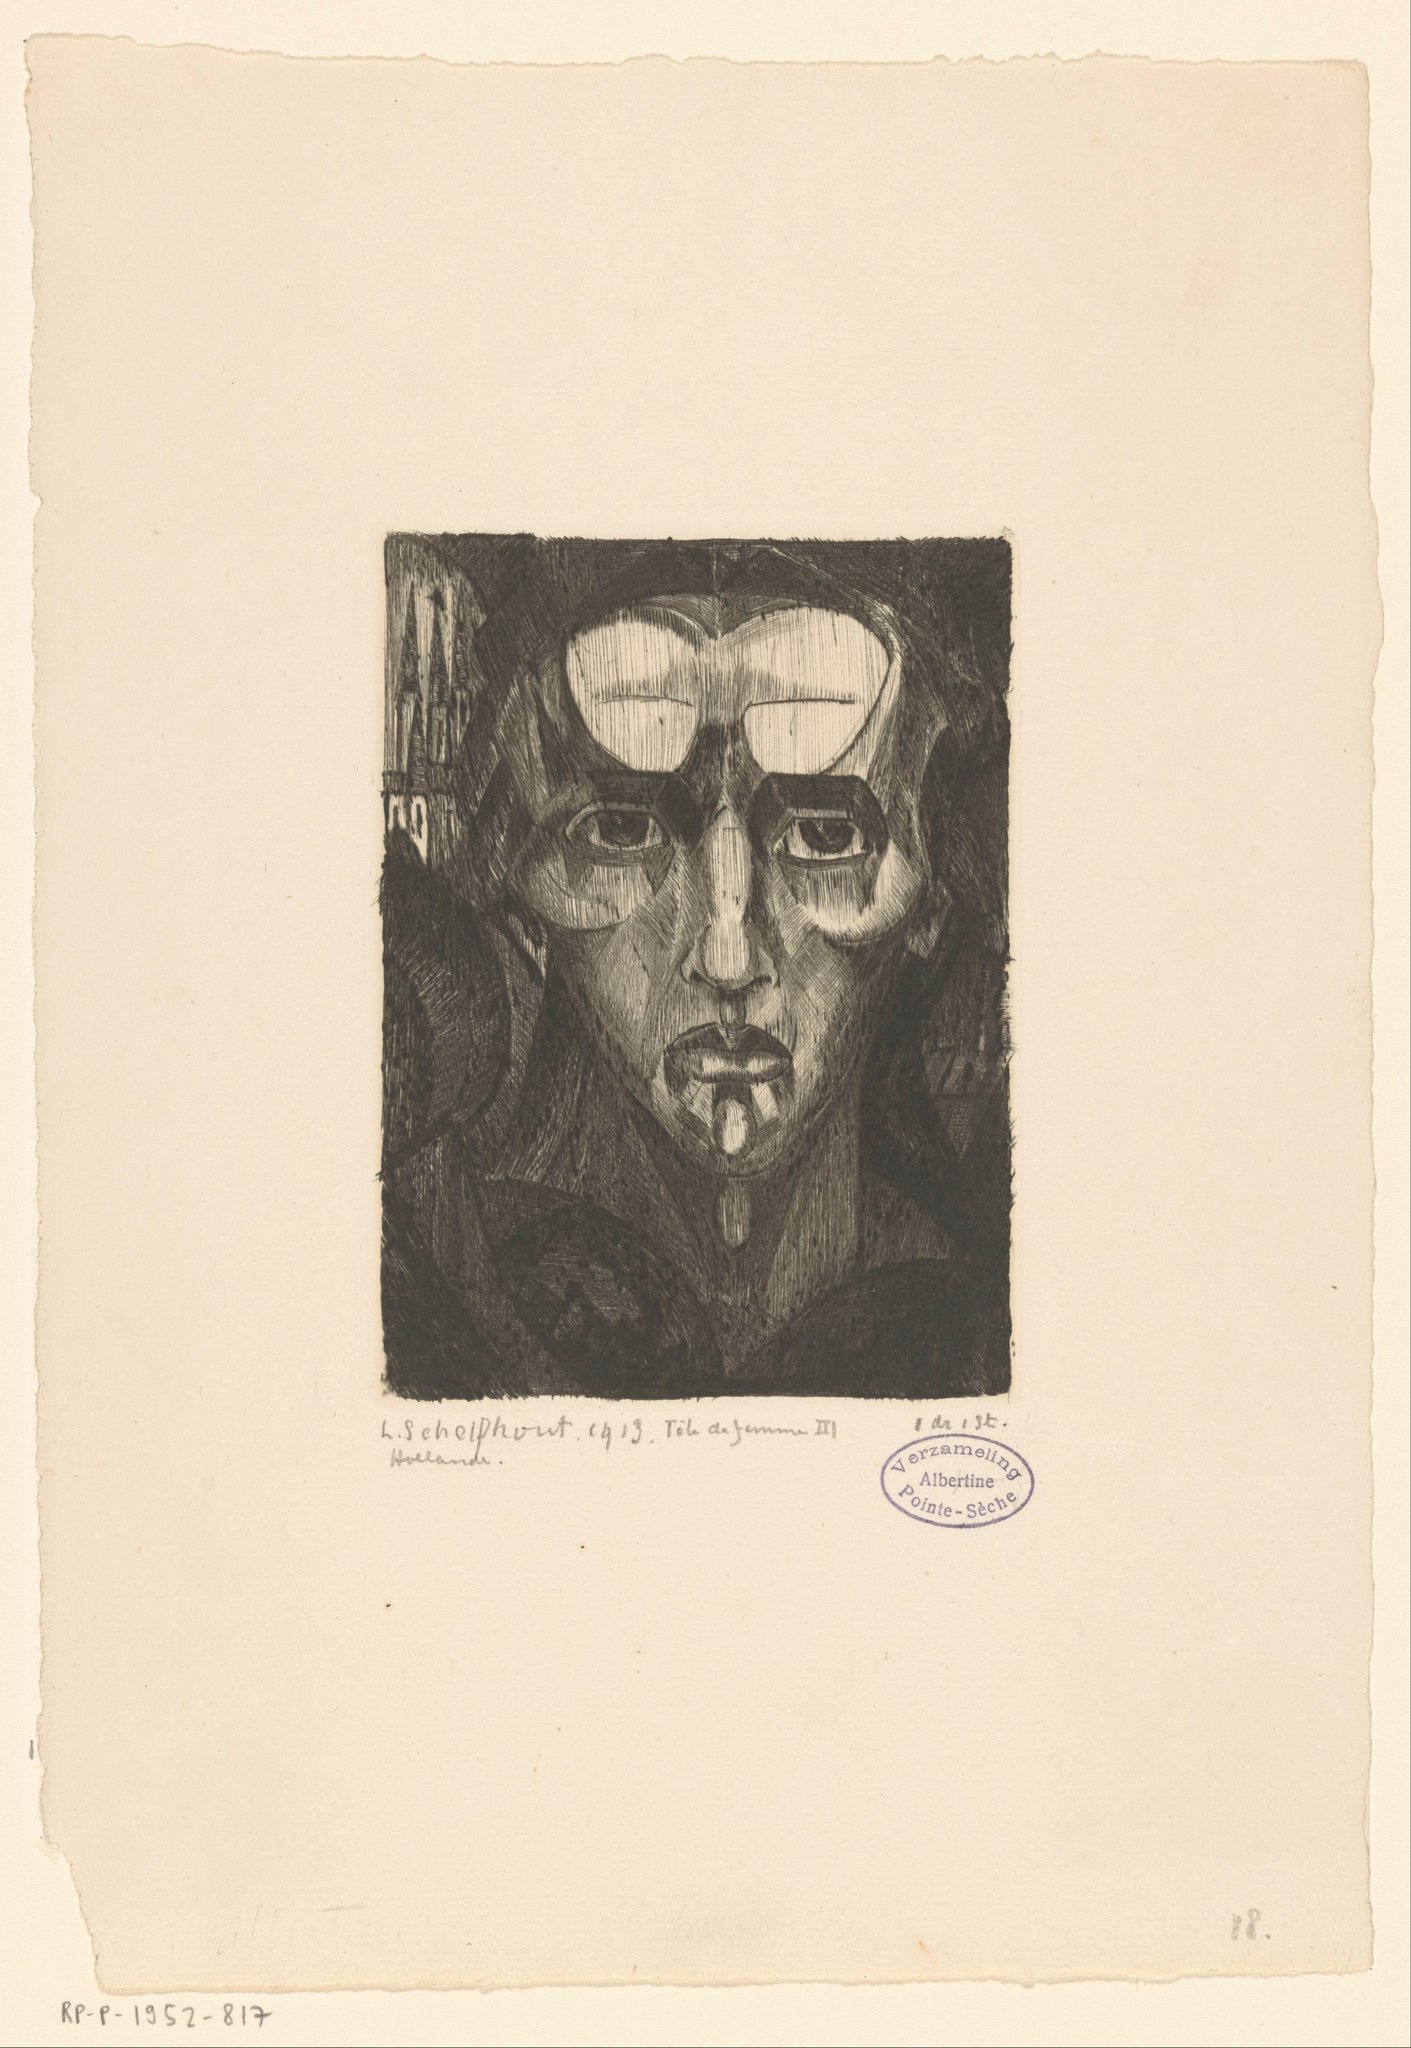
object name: print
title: Hoofd van een vrouw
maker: lodewijk schelfhout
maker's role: draughtsman, print maker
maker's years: 1881-1943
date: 1913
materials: paper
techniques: drypoint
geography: netherlands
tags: head (human) - aa - female human figure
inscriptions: collector's mark: Lugt 5i, collector's mark: Lugt 2228, collector's mark: Lugt 2760